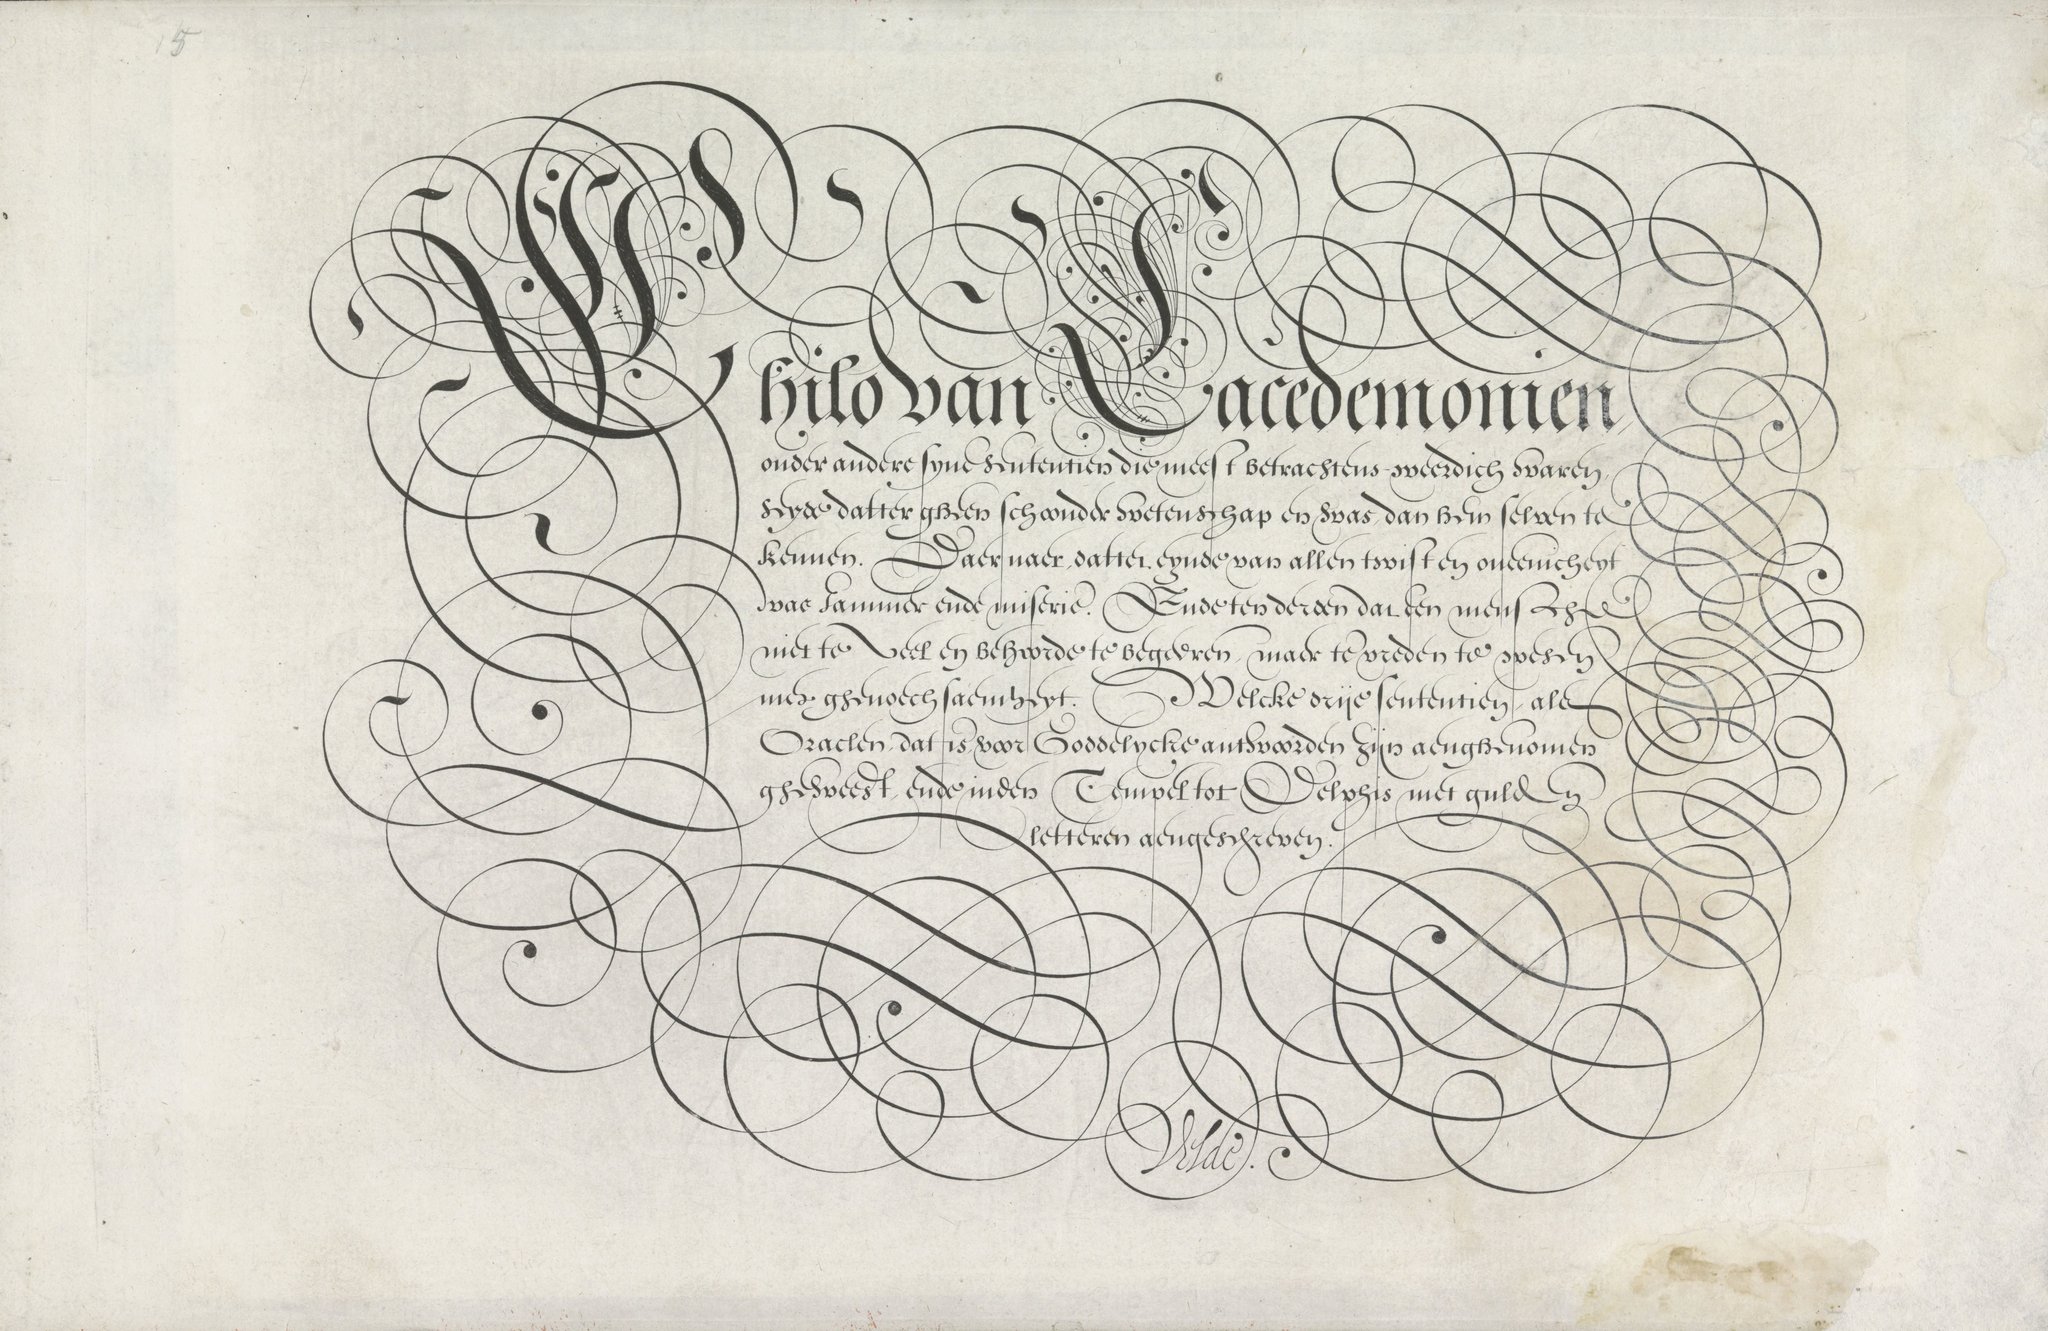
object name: print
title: Schrijfvoorbeeld: Chilo van Lacedemonien (...)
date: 1605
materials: paper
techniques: engraving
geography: haarlem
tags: calligraphy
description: Schrijfvoorbeeld met geornamenteerde initiaal C en L en tien regels tekst in het Nederlands: Chilo van Lacedemonien ... letteren aengeschreven. De tekst is omlijst door krulwerk. De prent maakt deel uit van een album.